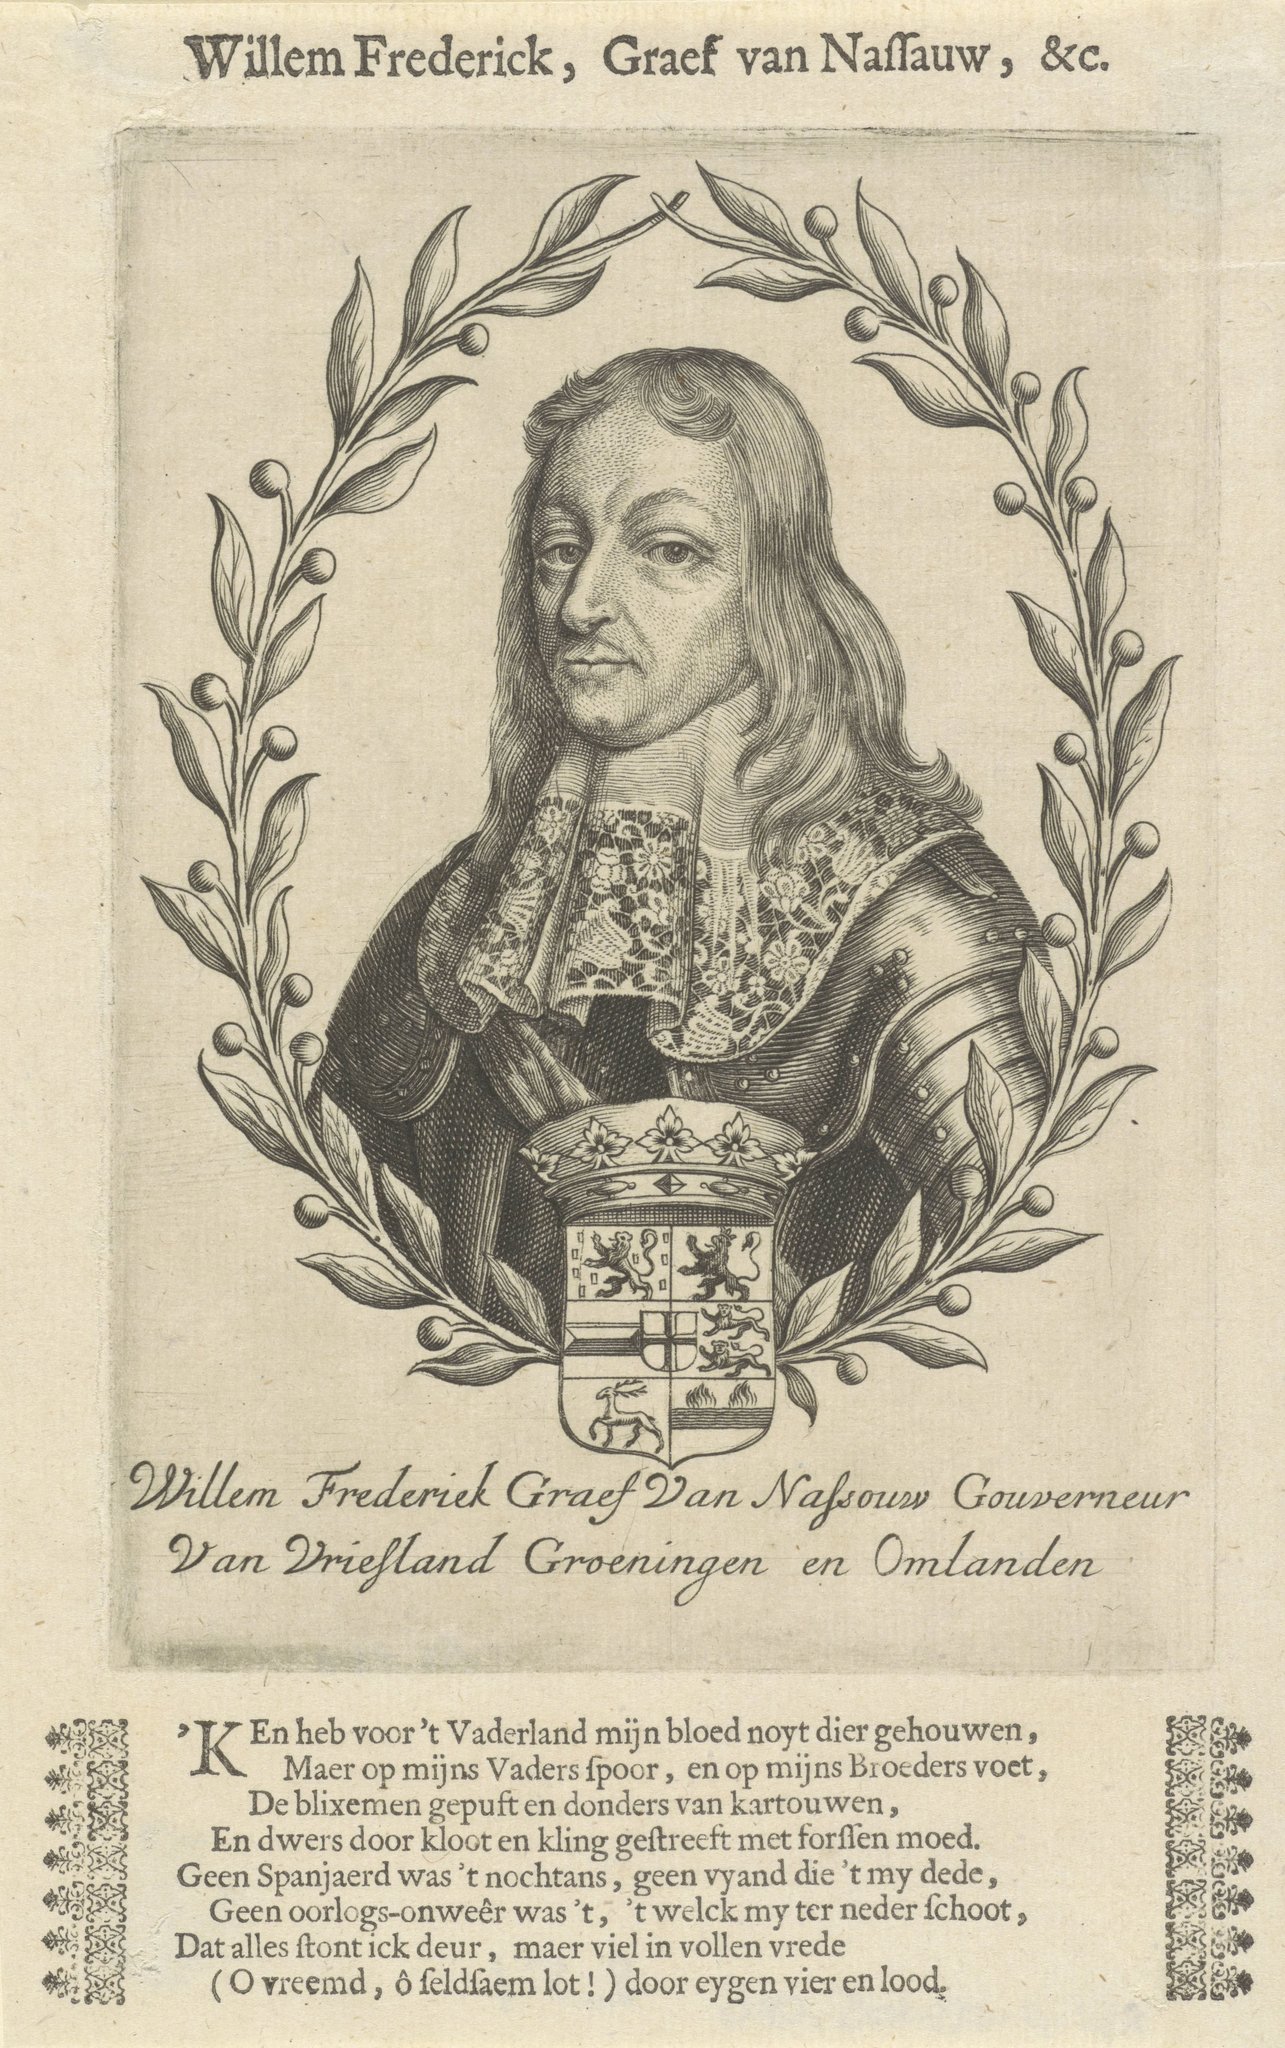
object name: print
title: Portret van Willem Frederik, graaf van Nassau-Dietz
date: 1667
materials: paper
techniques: engraving, etching, letterpress printing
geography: low countries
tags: arnhem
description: De hier vermelde titel verwijst naar de hoogst verkregen titel van de geportretteerde, niet per se naar de titel die de geportretteerde op deze voorstelling draagt. Prent uit: Scriverius, Petrus. Oude en nieuwe beschryvinghe van Holland, Zeeland en Vriesland. Den Haag: Levijn van Dijck, 1667.